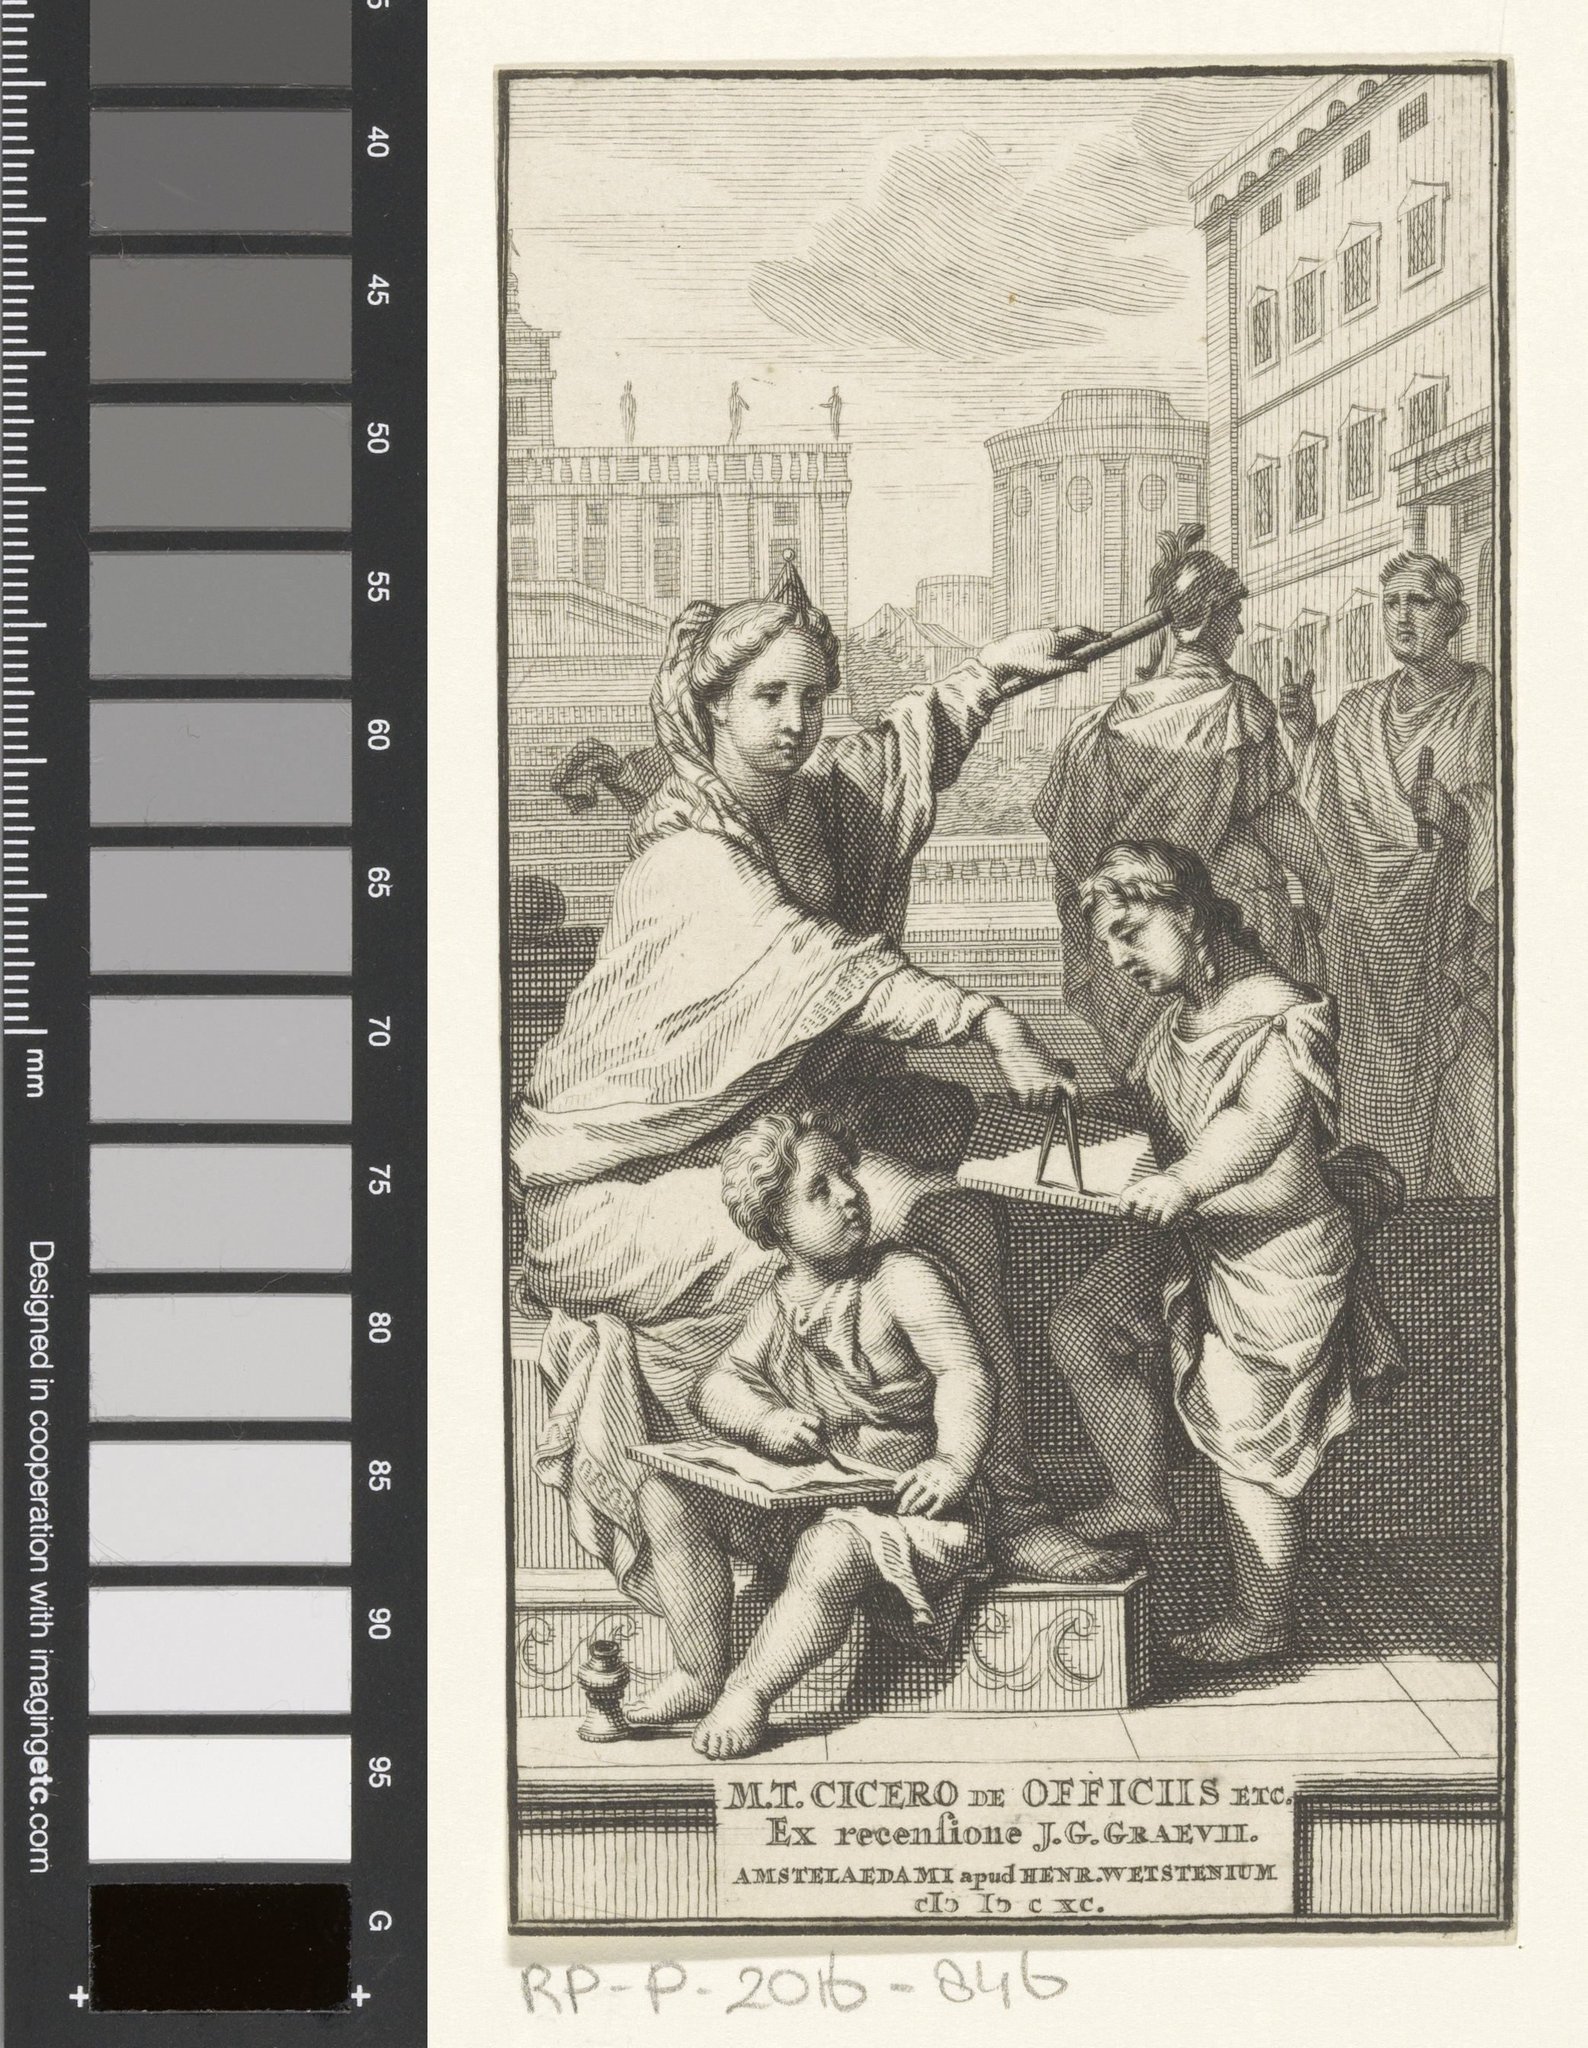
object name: print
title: Vrouw met passer en Cicero in gesprek met soldaat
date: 1690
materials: paper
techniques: engraving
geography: amsterdam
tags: (story of) cicero, drawing (mathematics), compasses, conversation, dialogue; conversation piece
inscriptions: collector's mark: Lugt 240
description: Een zittende vrouw houdt een passer op een tablet vastgehouden door een kleine mens. In haar linkerhand houdt zij een staf omhoog. Voor haar schrijft een putto op een vel papier. Rechts spreekt een man, mogelijk Cicero, met een soldaat op de rug gezien.